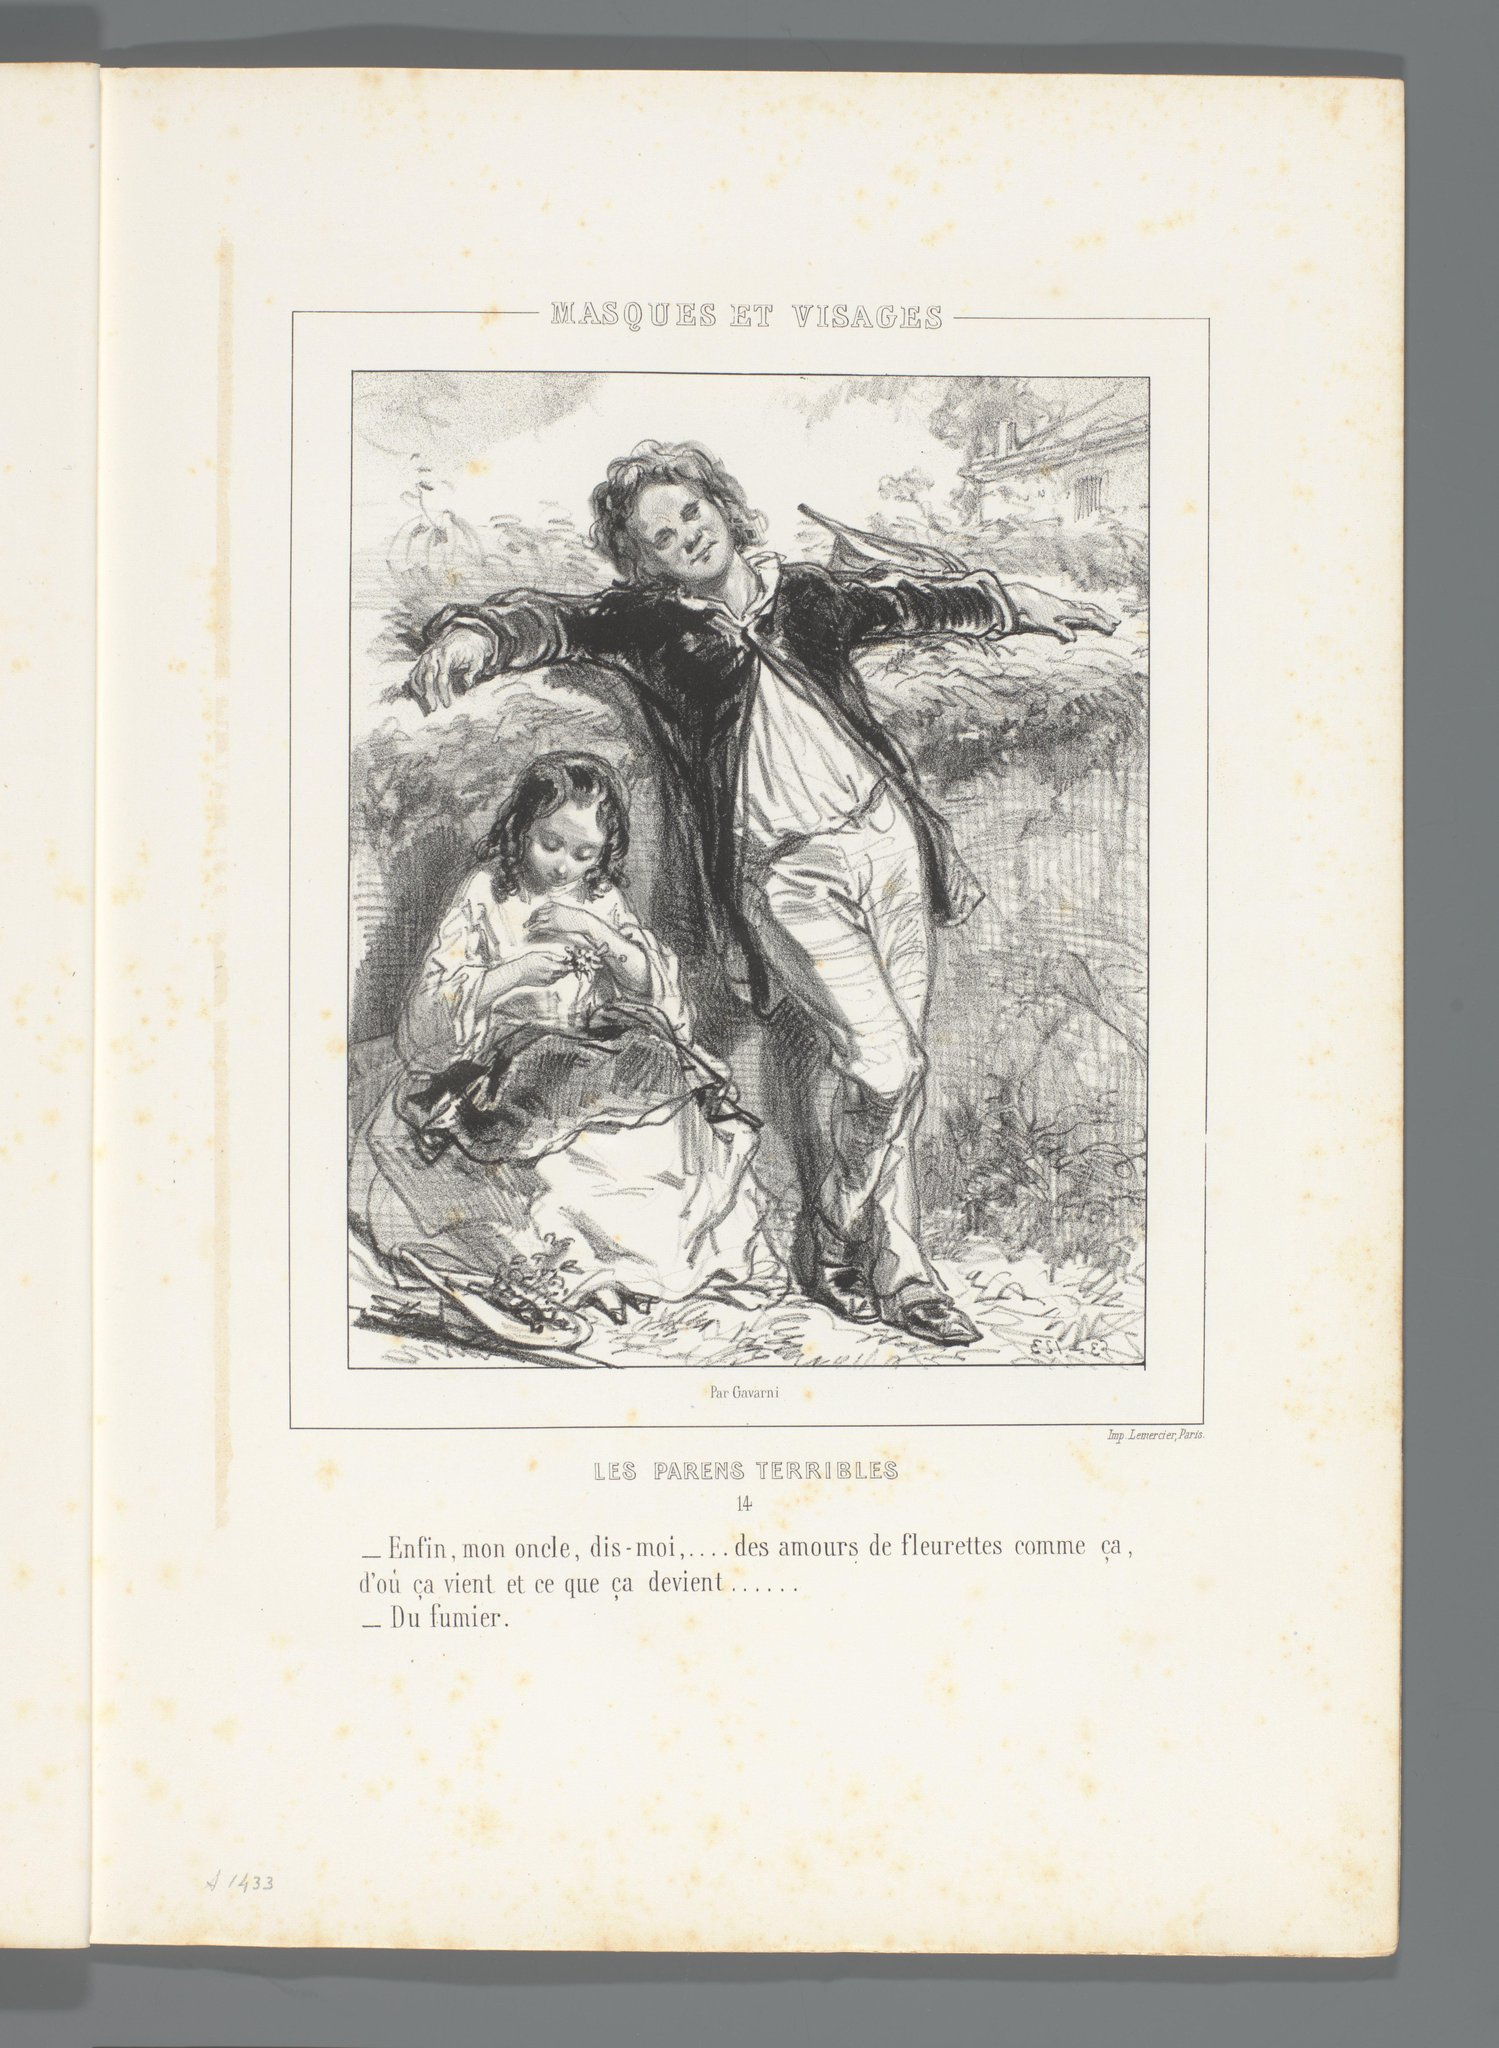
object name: album leaf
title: Masques et visages. Les parents terribles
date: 1853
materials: paper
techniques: lithograph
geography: paris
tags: adolescent, young woman, maiden, cut flowers; nosegay, bunch of flowers, uncles, aunts (third degree family relationships)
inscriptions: collector's mark: Lugt 2228a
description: Prent gebruikt voor: Paris (Journal), 8 juni 1853.